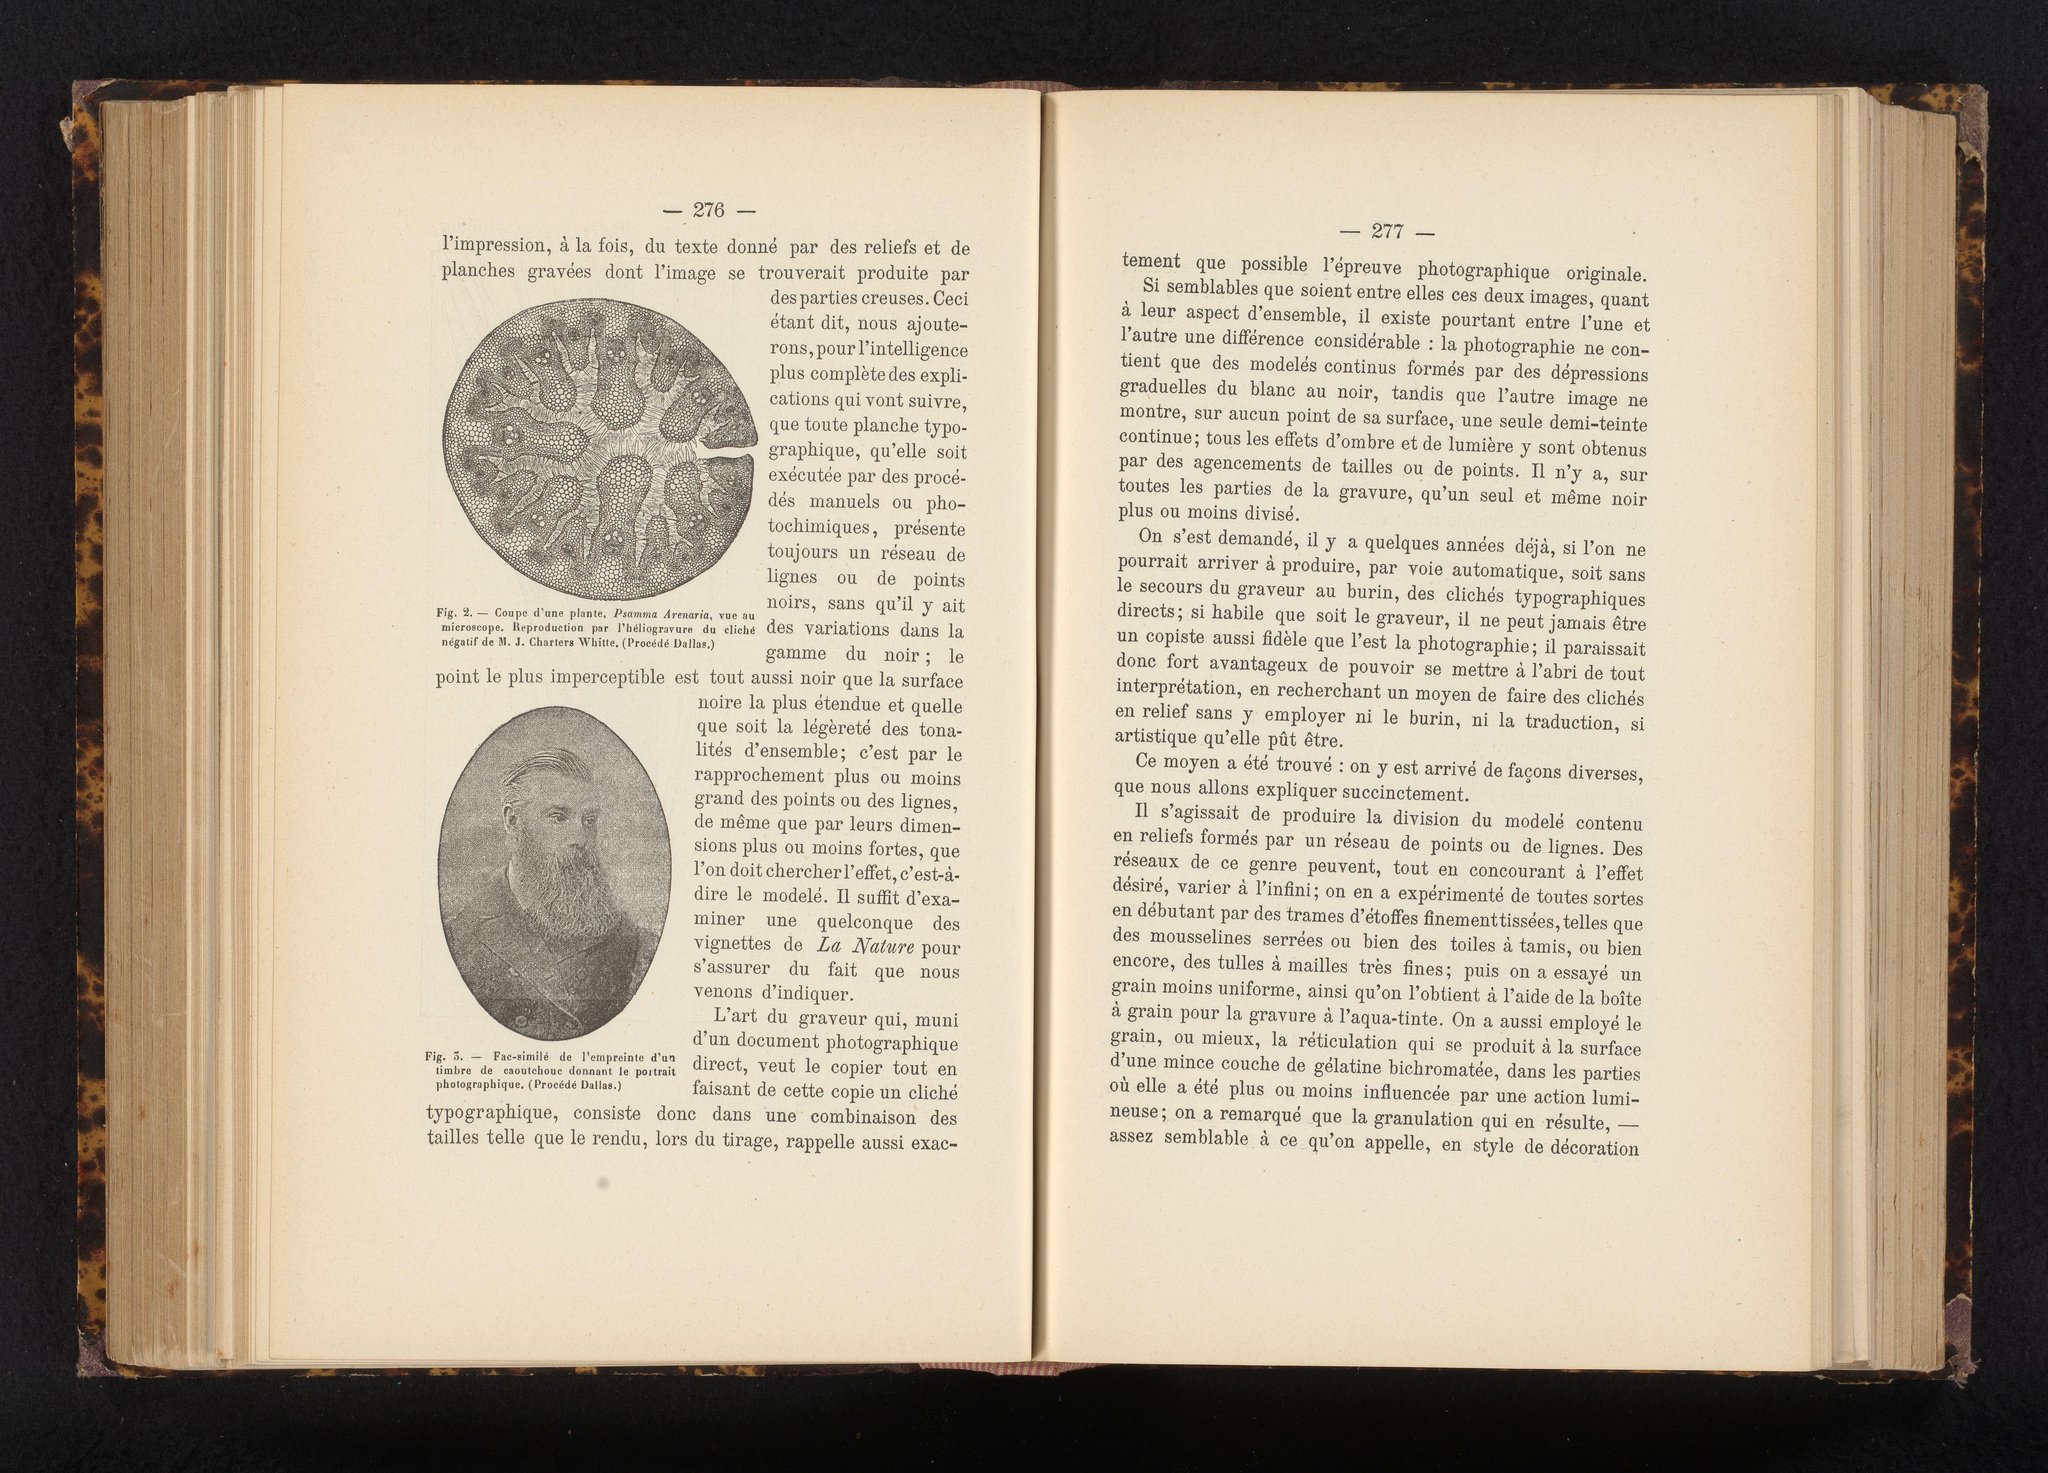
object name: page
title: Coupe d'une plante, Psamma Arenaria, vue au microscope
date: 1881-1886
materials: paper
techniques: photolithography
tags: plants (in general)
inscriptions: inscription: ‘Fig. 2. (...) Reproduction par l'héliogravure du cliché/ négatif de M. J. Charters Whitte. (Procédé Dallas.)’